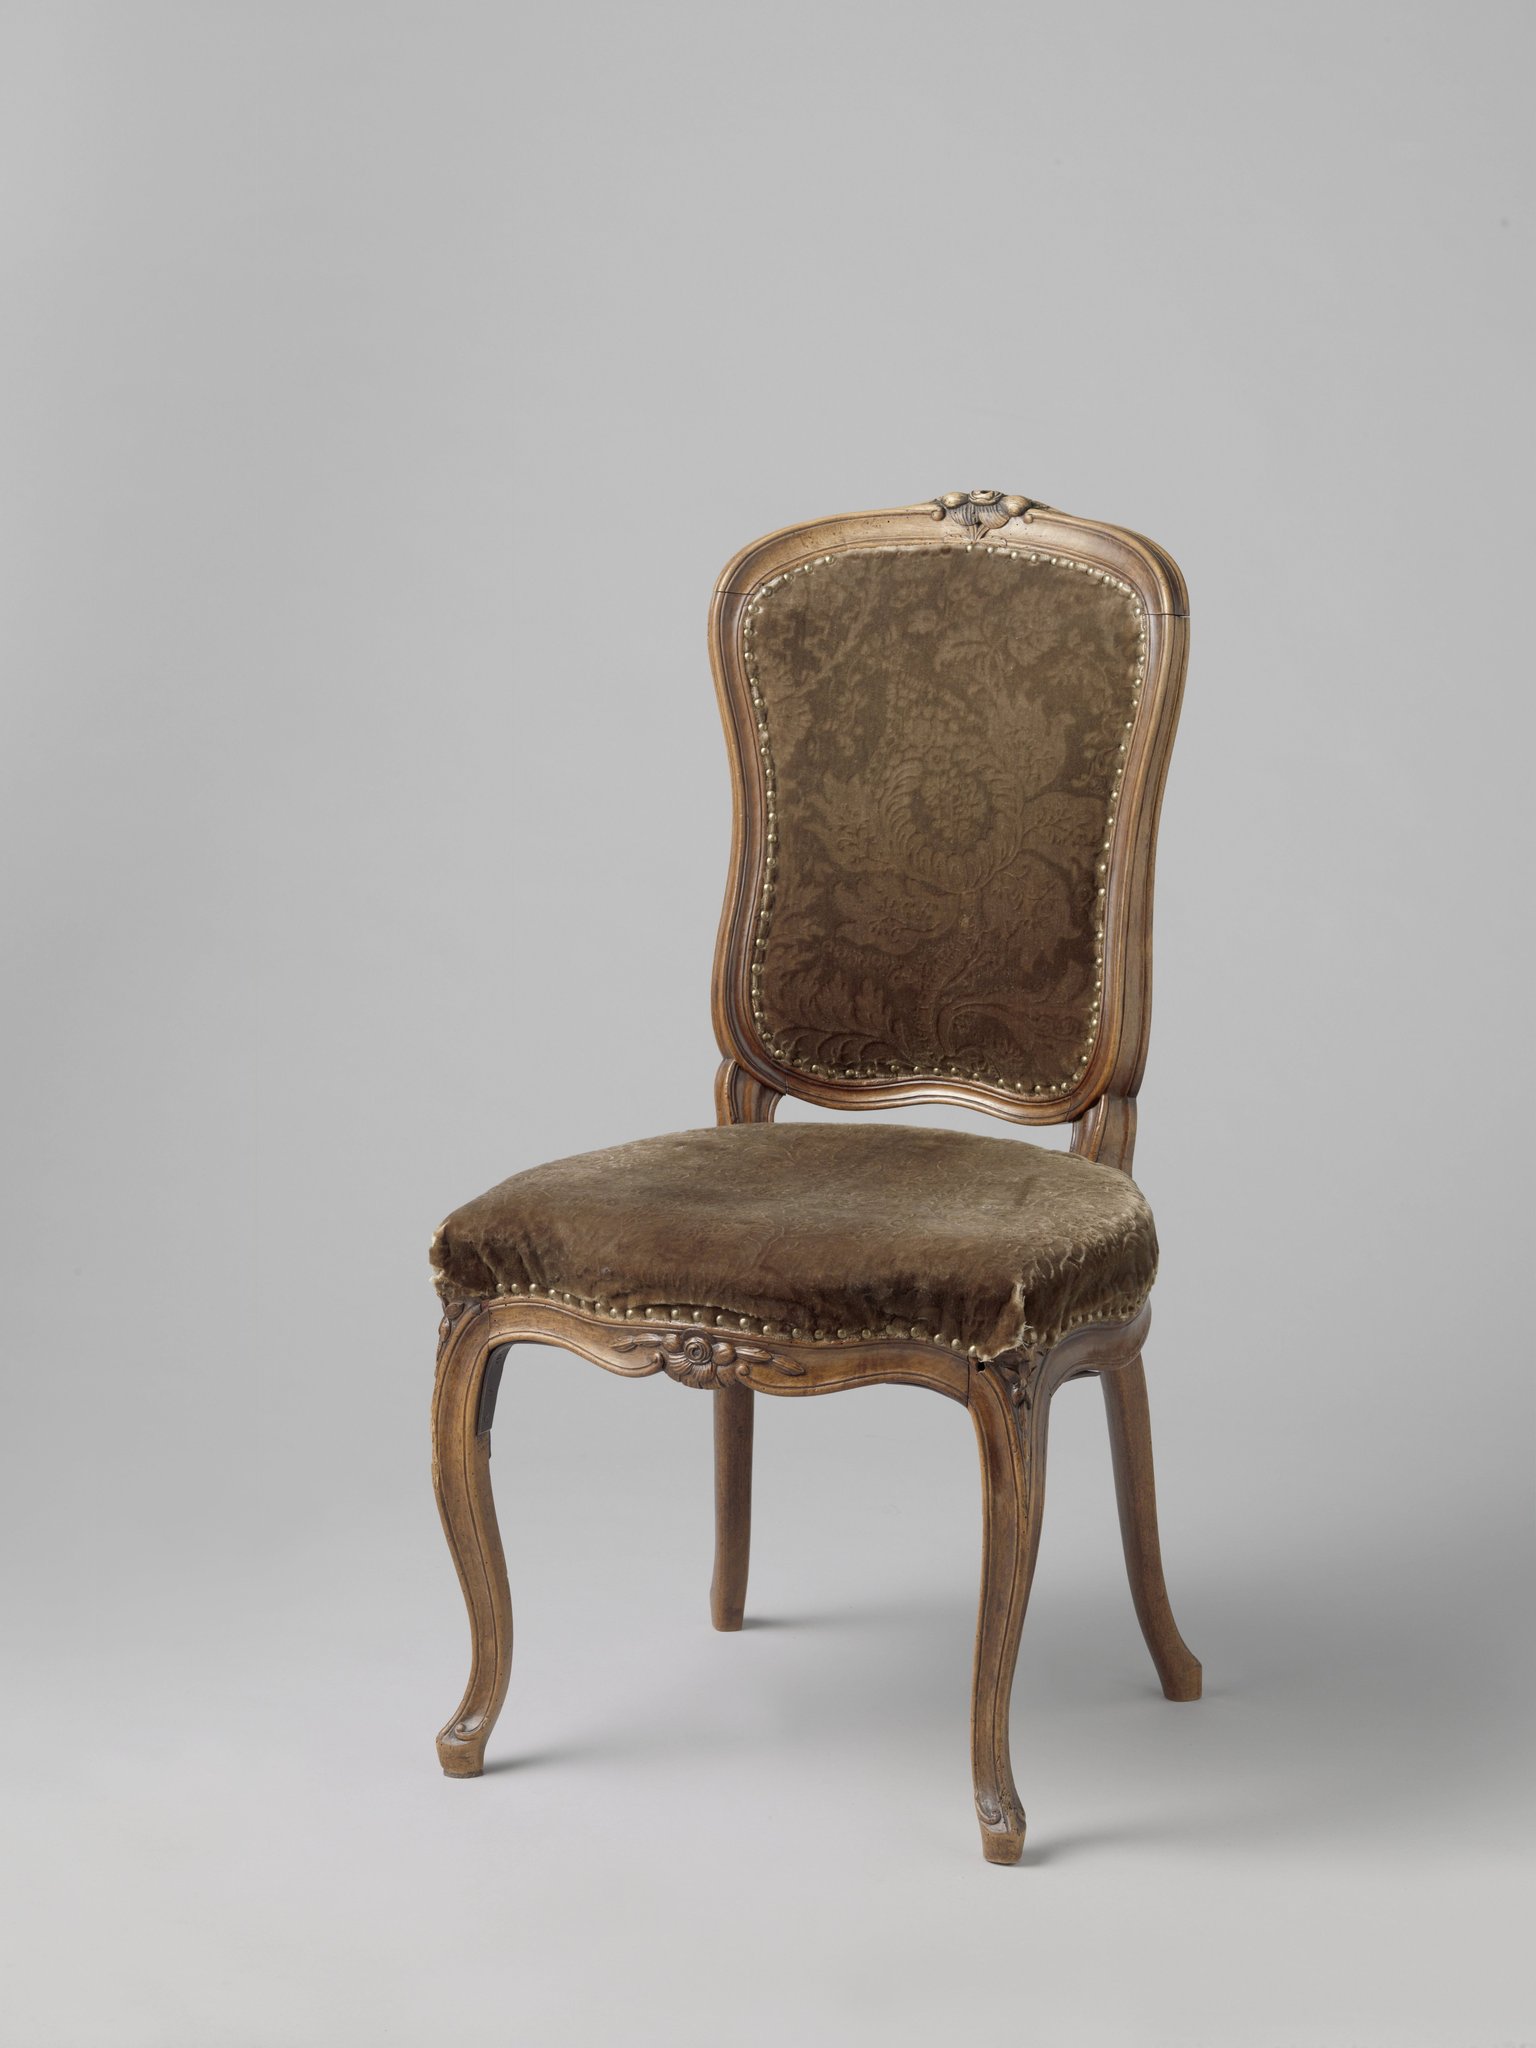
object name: furniture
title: Stoel met overhoeks geplaatste S-vormige poten op bokshoeven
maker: Anonymous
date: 1740-1760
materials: textile, wood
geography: northern netherlands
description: Stoel behorende tot ameublement bestaande uit zes beklede notenhouten stoelen en één armstoel, rustend op overhoeks geplaatste gestrekt S-vormige poten op bokshoeven, die in het zitraam overgaan. Het geronde, aan de voorkant geschulpte, zitraam draagt versieringen in bloemmotief; evenals de bovendorpel van het langwerpige beklede rugraam dat van onderen en van opzij iets geschulpt is. De gestrekt S-vormige armleggers worden gesteund door achterwaarts geplaatste gestrekt S-vormige stutten met voluut- en acanthusbladversiering.